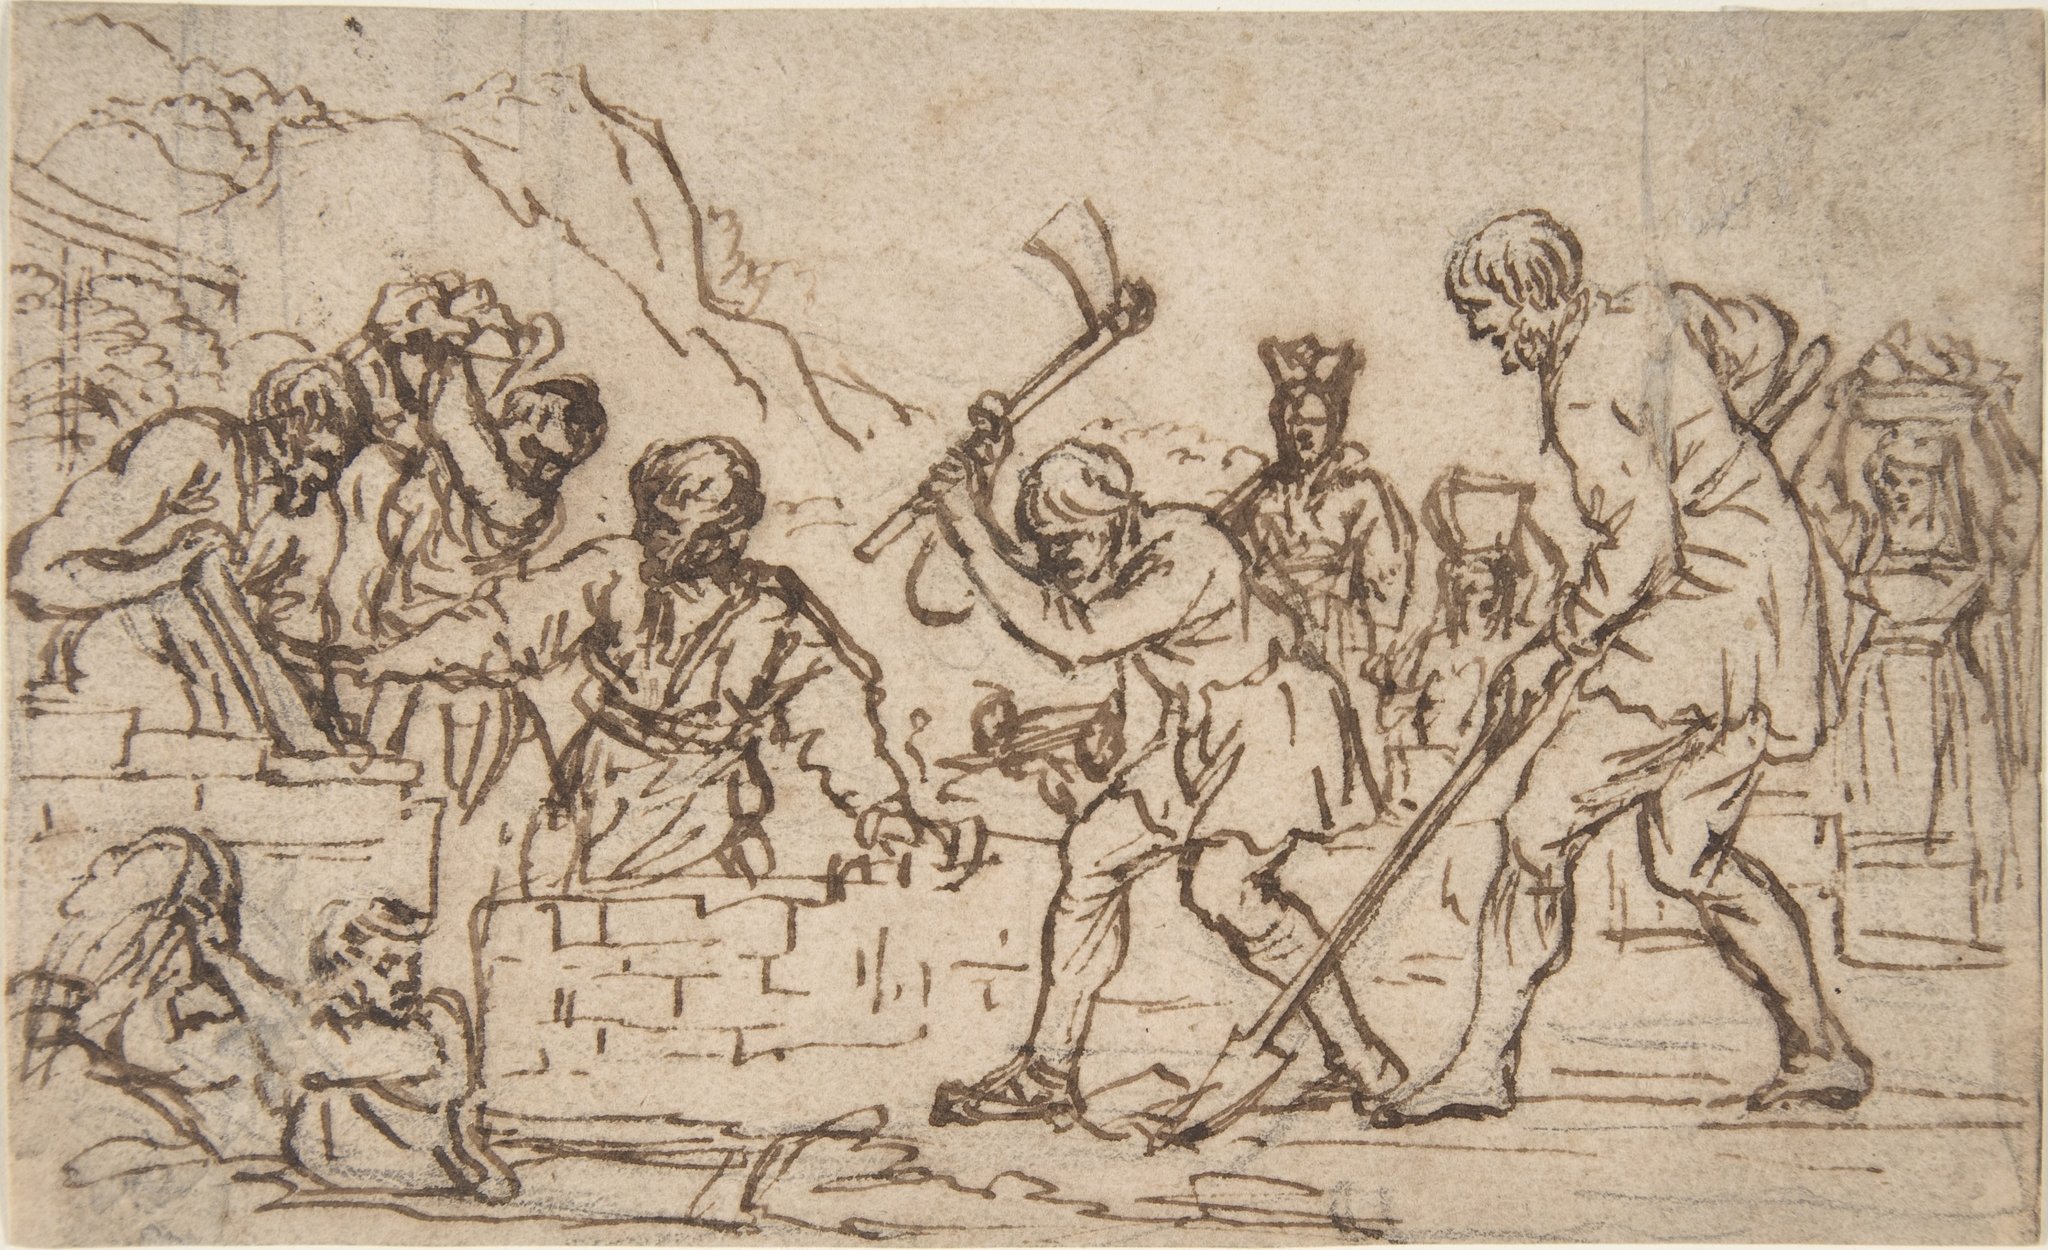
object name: drawing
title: Men Digging and Constructing a Wall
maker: pietro da cortona (pietro berrettini)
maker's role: artist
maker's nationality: italian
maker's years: 1596-1669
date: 1601-1700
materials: chalk, ink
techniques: pen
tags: men,working,axes